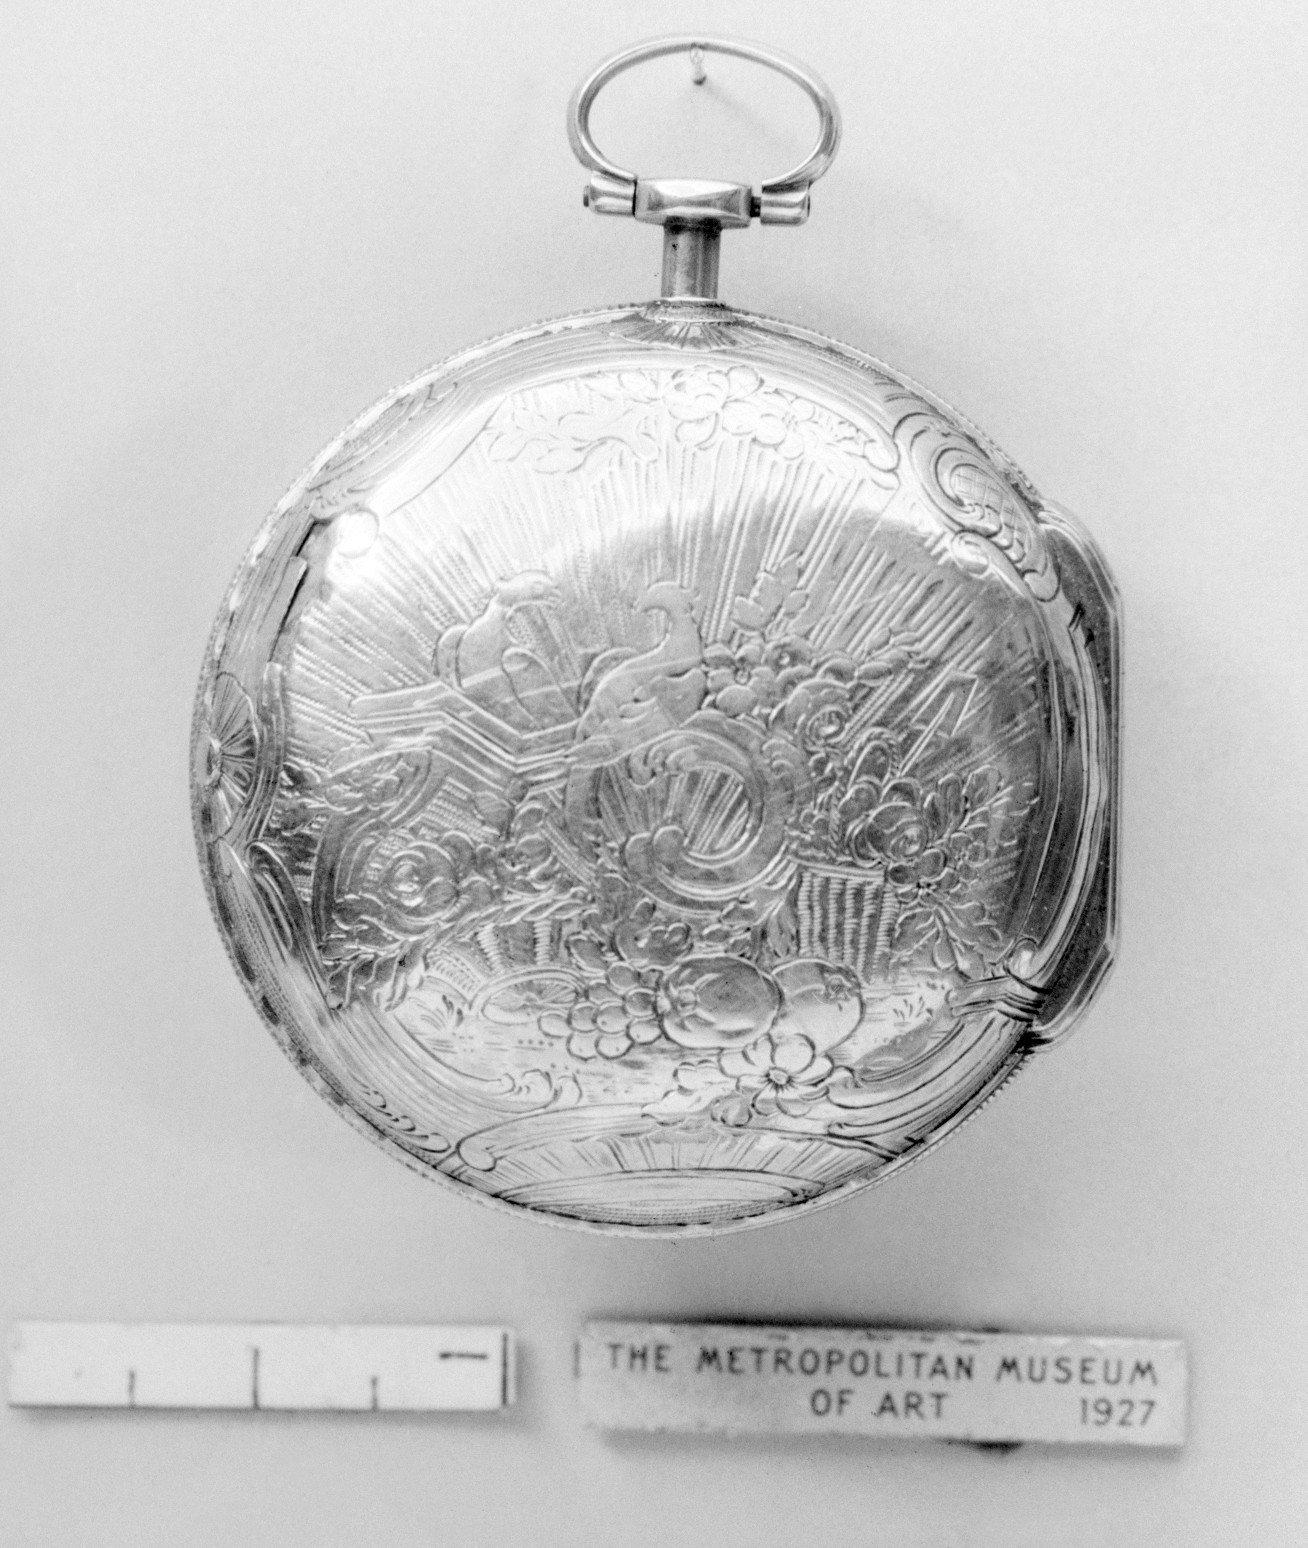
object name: watch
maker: franz georg rothea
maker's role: maker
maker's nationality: french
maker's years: 1737-1742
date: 1701-1800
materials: enamel, gold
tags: birds